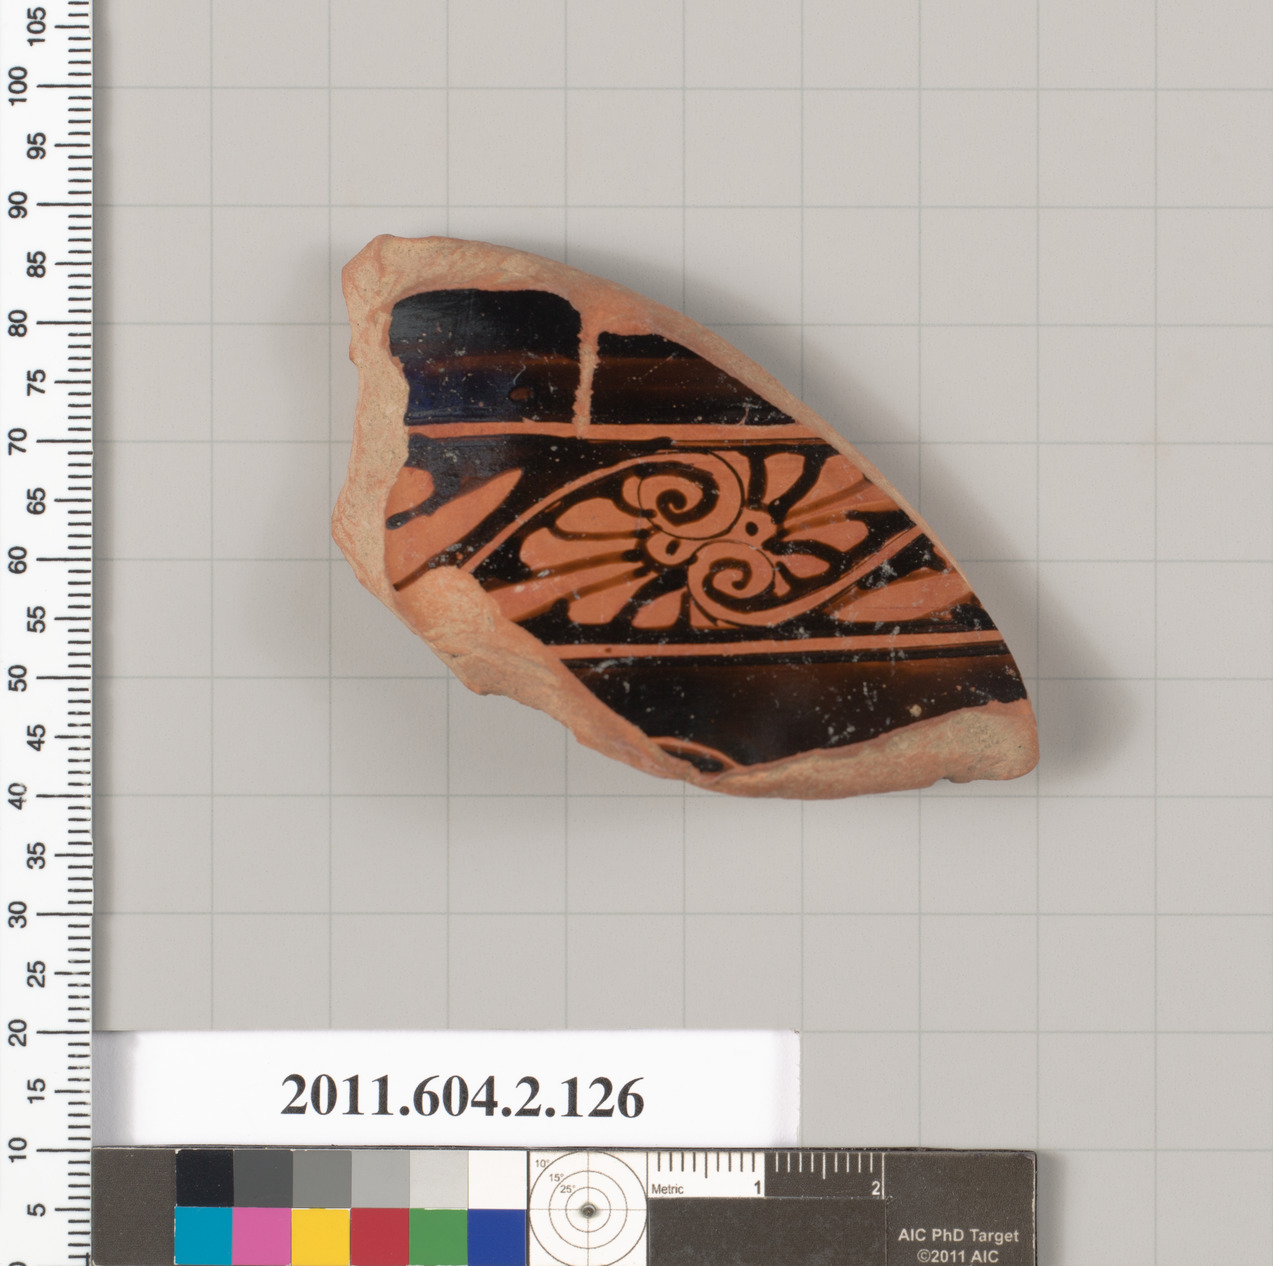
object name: pelike fragment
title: Terracotta fragment of a pelike (jar)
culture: greek, attic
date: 467-435 BCE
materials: terracotta